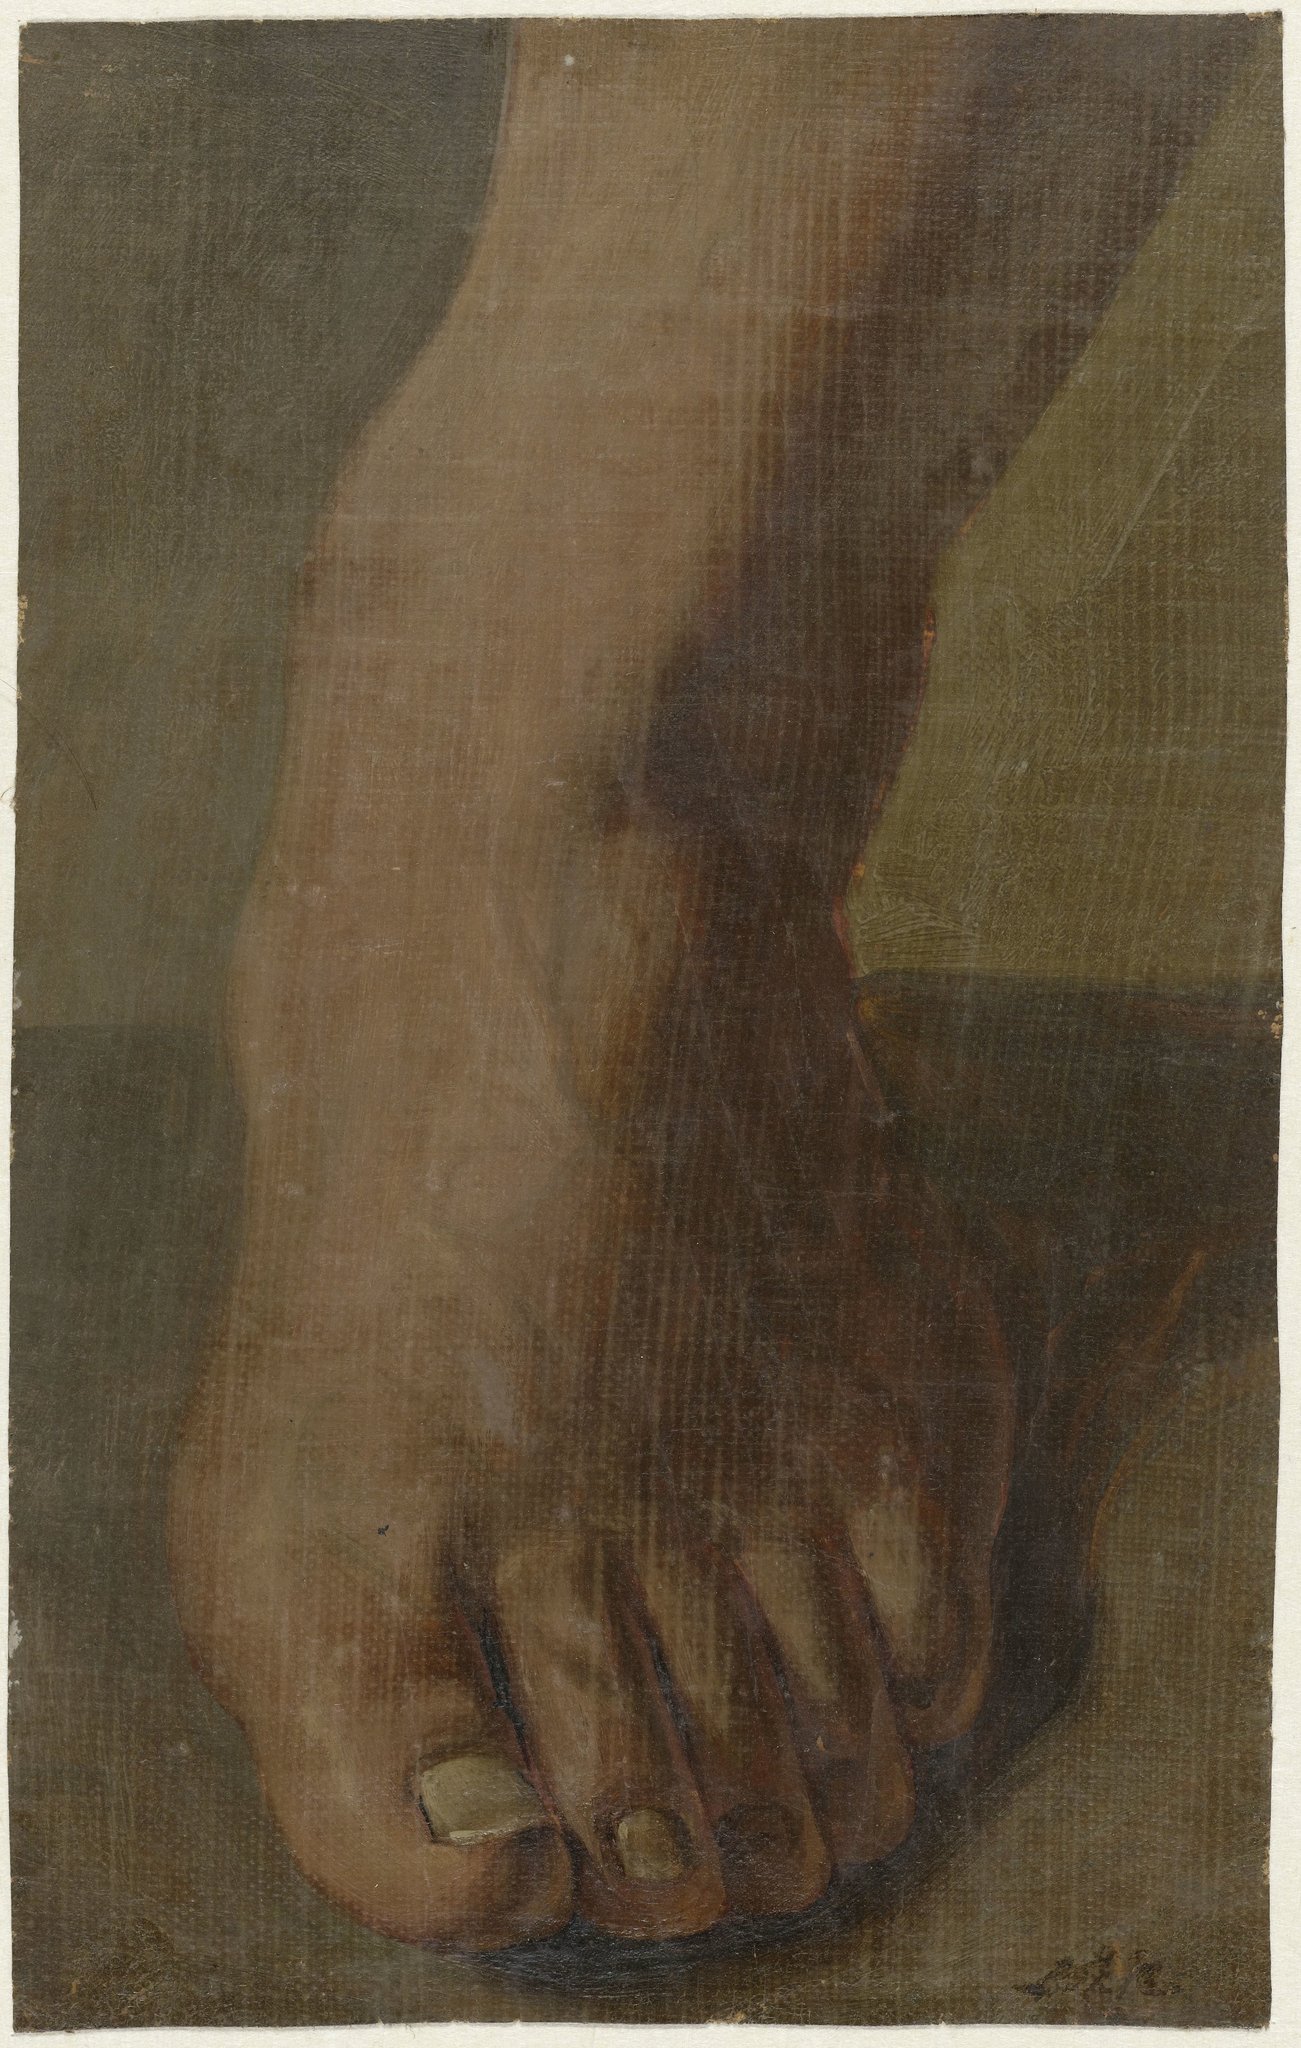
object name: painting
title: A Left Foot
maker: simon andreas krausz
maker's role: draughtsman, print maker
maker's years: 1760-1825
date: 1770-1825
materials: linen, oil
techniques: brush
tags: foot